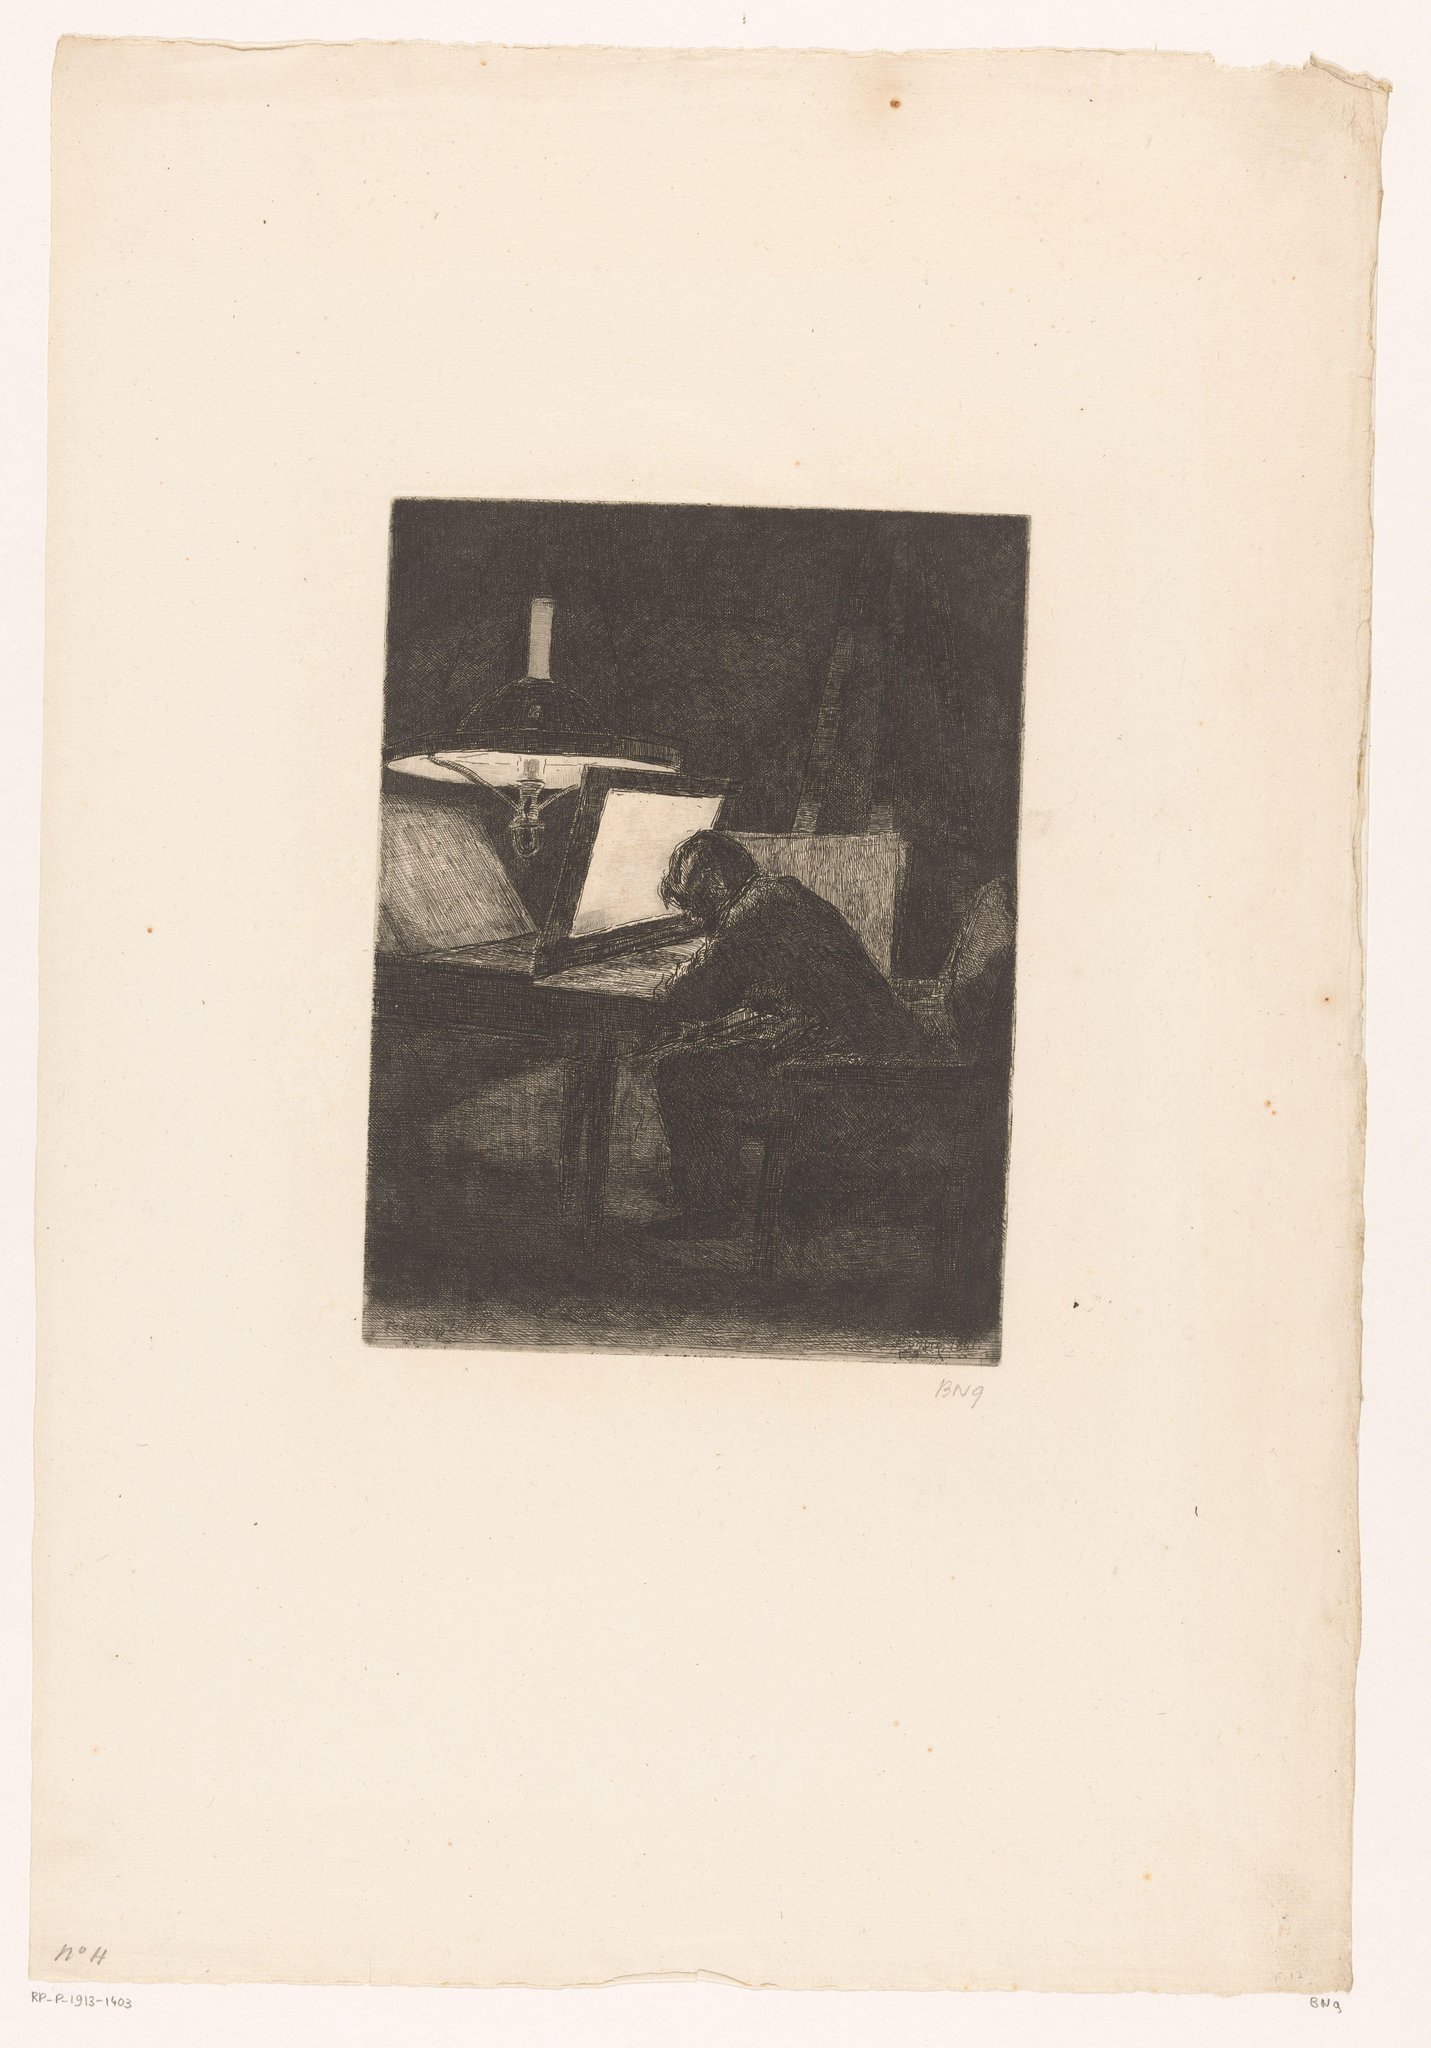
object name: print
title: Six Eaux-fortes, dessinées et gravées par F. Bonvin, Peintre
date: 1861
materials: paper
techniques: etching, intaglio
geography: paris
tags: engraver, etcher, artist at work, in his workshop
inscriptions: collector's mark: Lugt 2233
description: Maakt deel uit van een zesdelige serie, getiteld: Six Eaux-fortes, dessinées et gravées par F. Bonvin, Peintre. De eerste staat werd in 1861 door Bonvin uitgegeven in Parijs.